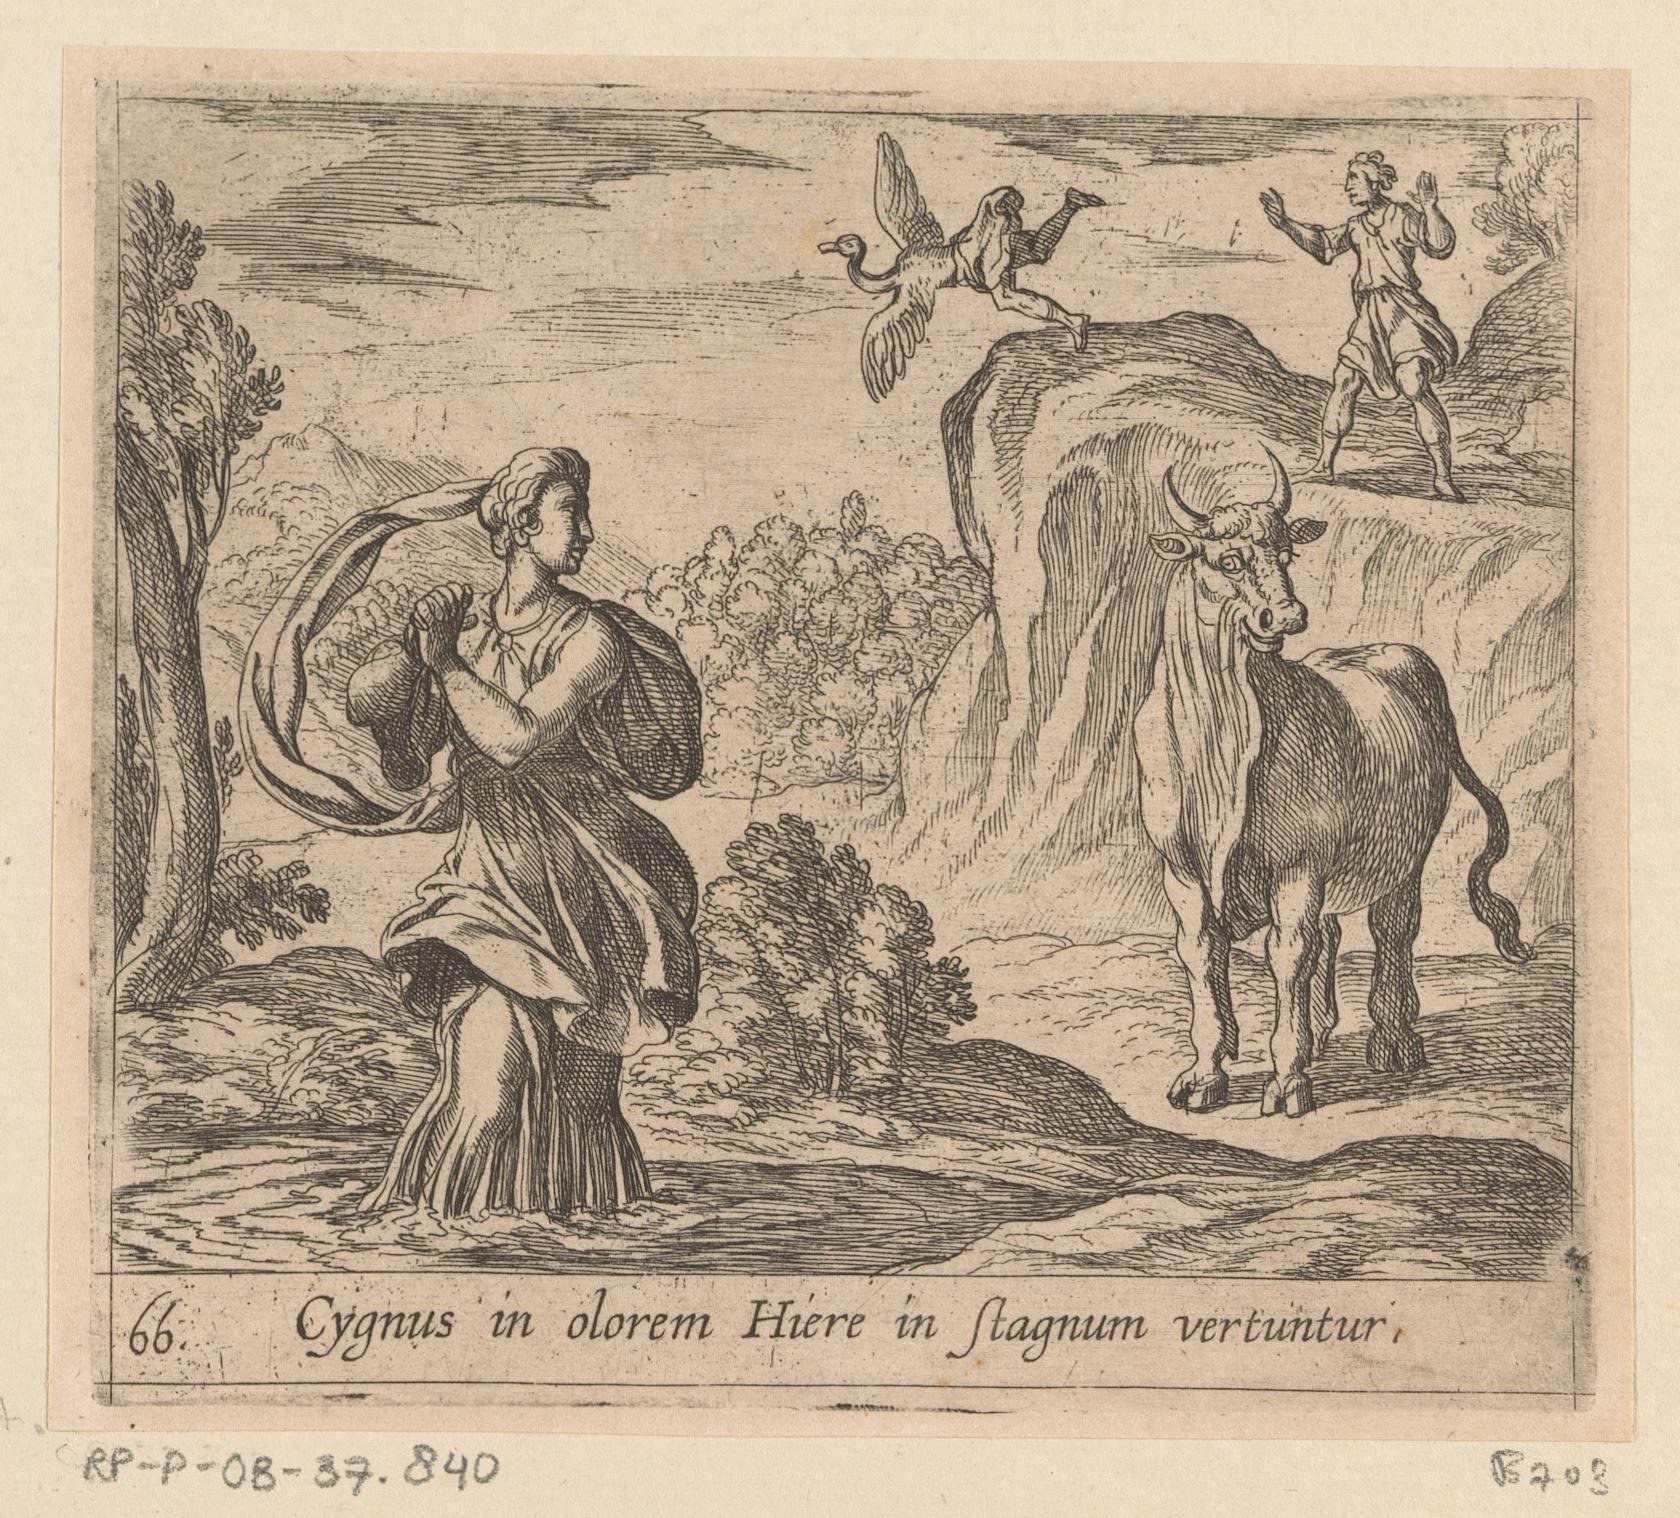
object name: print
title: Cygnus in olorem Hiere in stagnum vertuntur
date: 1606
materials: paper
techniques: etching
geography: antwerp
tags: cygnus, son of apollo, changed into a swan: because his friend phil(l)ius refused to give him the bull captured by the help of hercules, cycnus, the son of apollo, leaps off a cliff, and is changed into a swan (ovid, metamorphoses vii 371), hyrie changed into a fountain: in her grief for the loss of cycnus, her son by apollo, hyrie is changed into a fountain (ovid, metamorphoses vii 380)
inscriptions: collector's mark: Lugt 240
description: Ontdaan omdat Phylius weigert de door hem gevangen stier aan hem te geven, springt Cygnus van een rots waarop hij door zijn vader Apollo wordt veranderd in een zwaan. Zijn bedroefde moeder Hyrie wordt veranderd in een fontein. Titel in het Latijn in ondermarge.